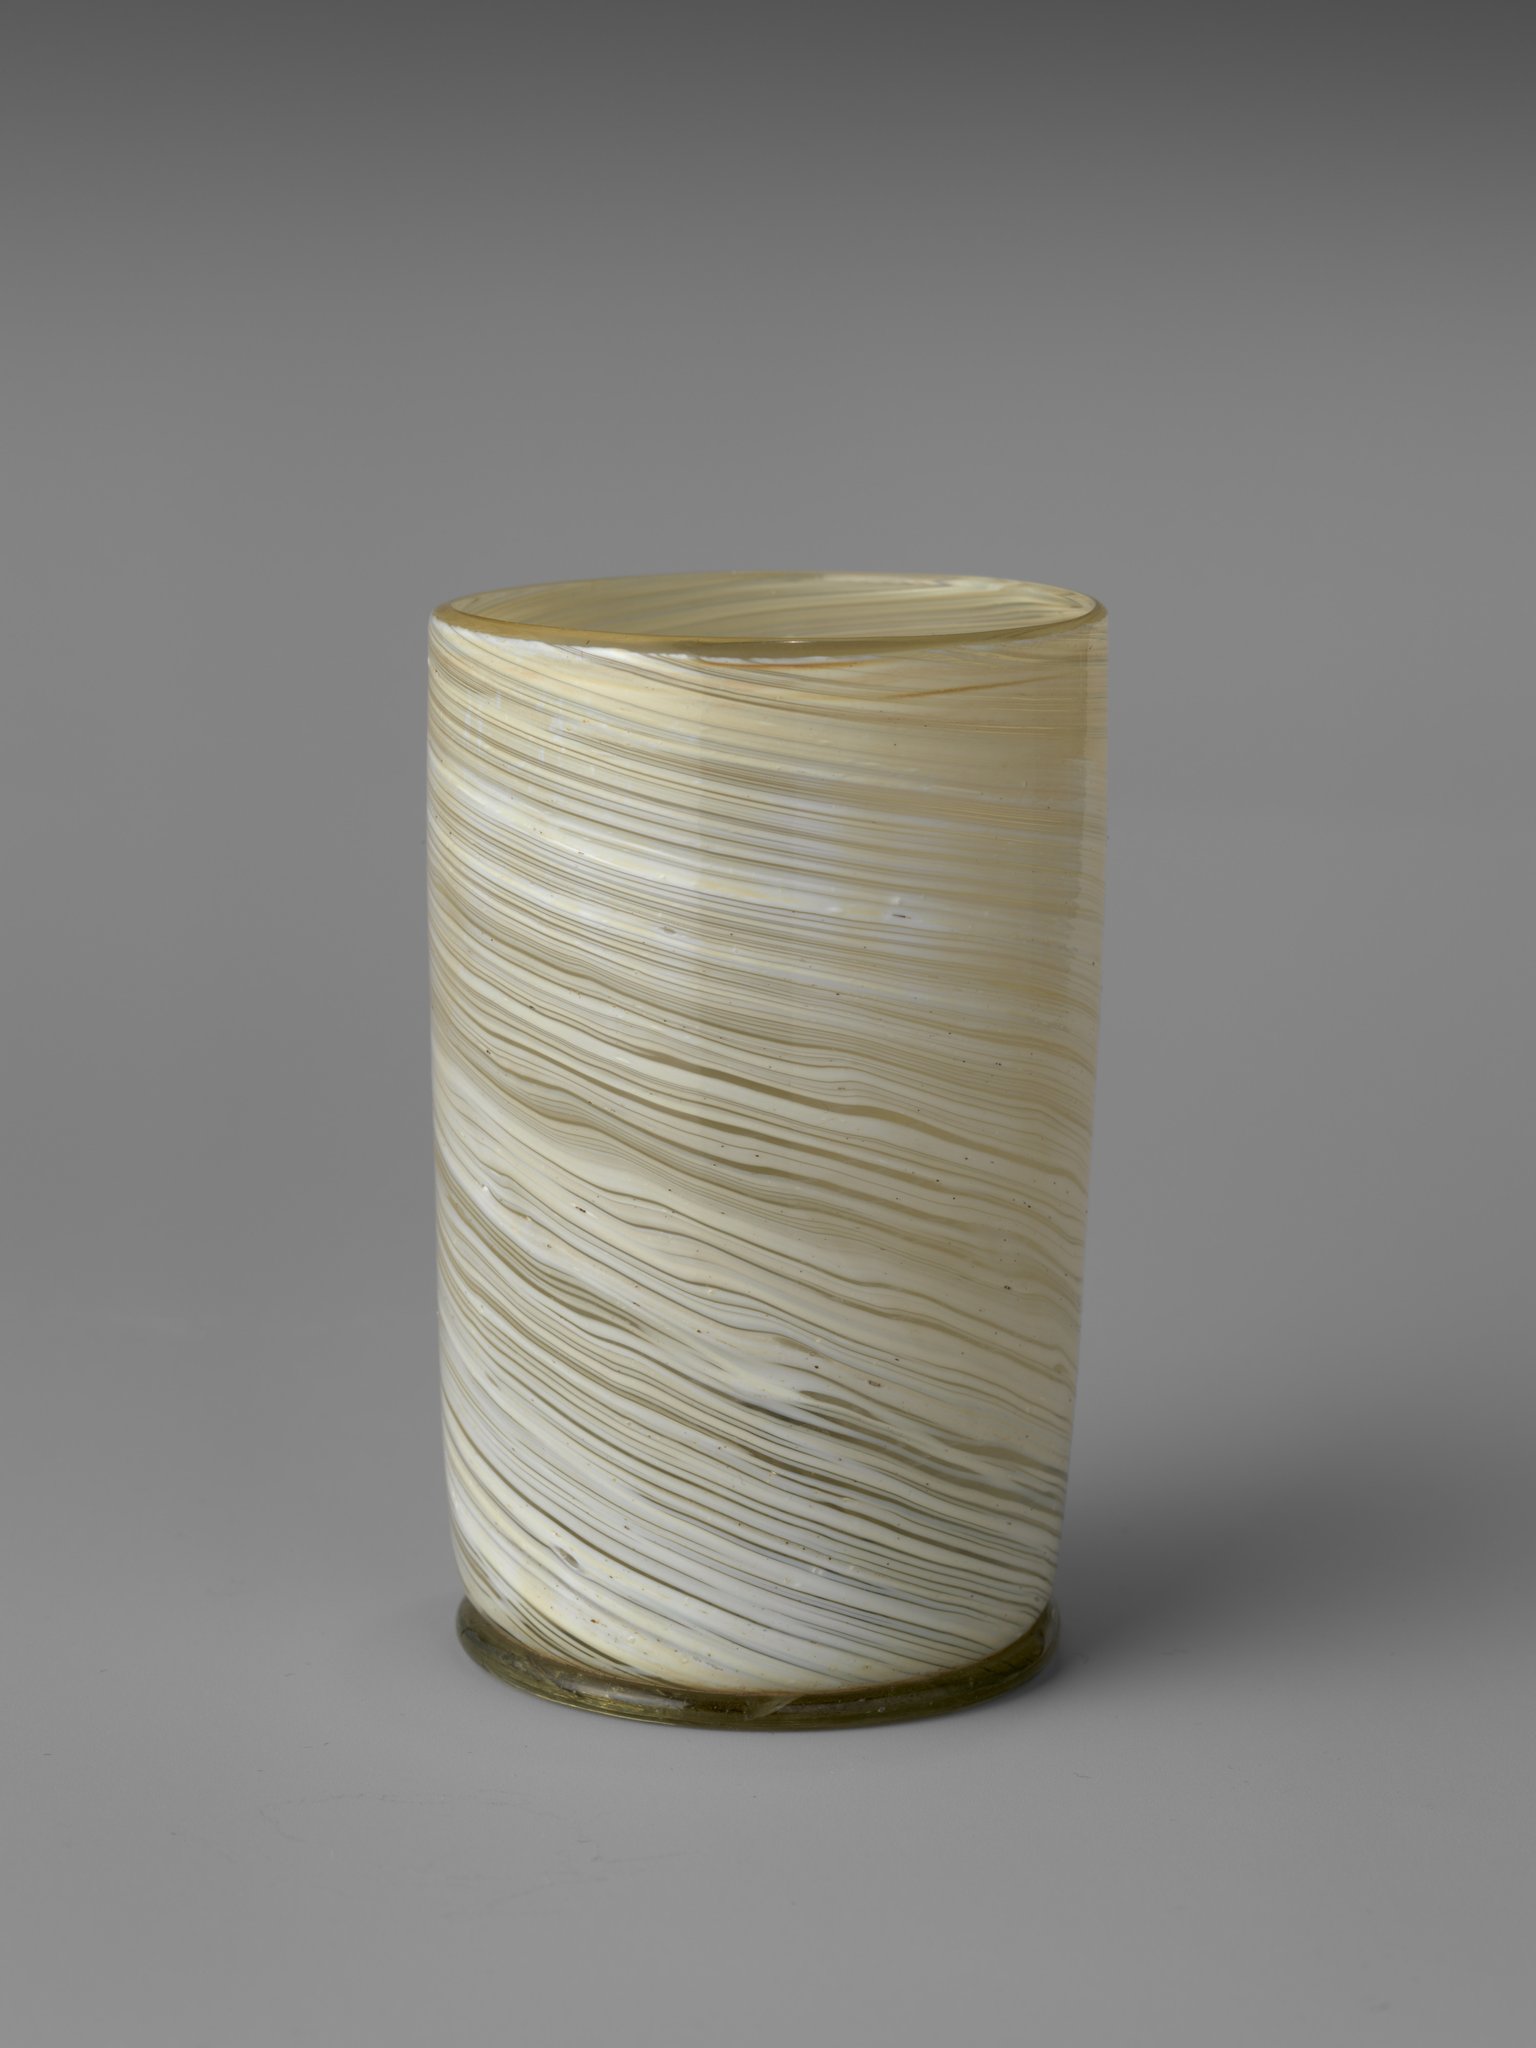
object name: beaker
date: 1601-1800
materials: glass